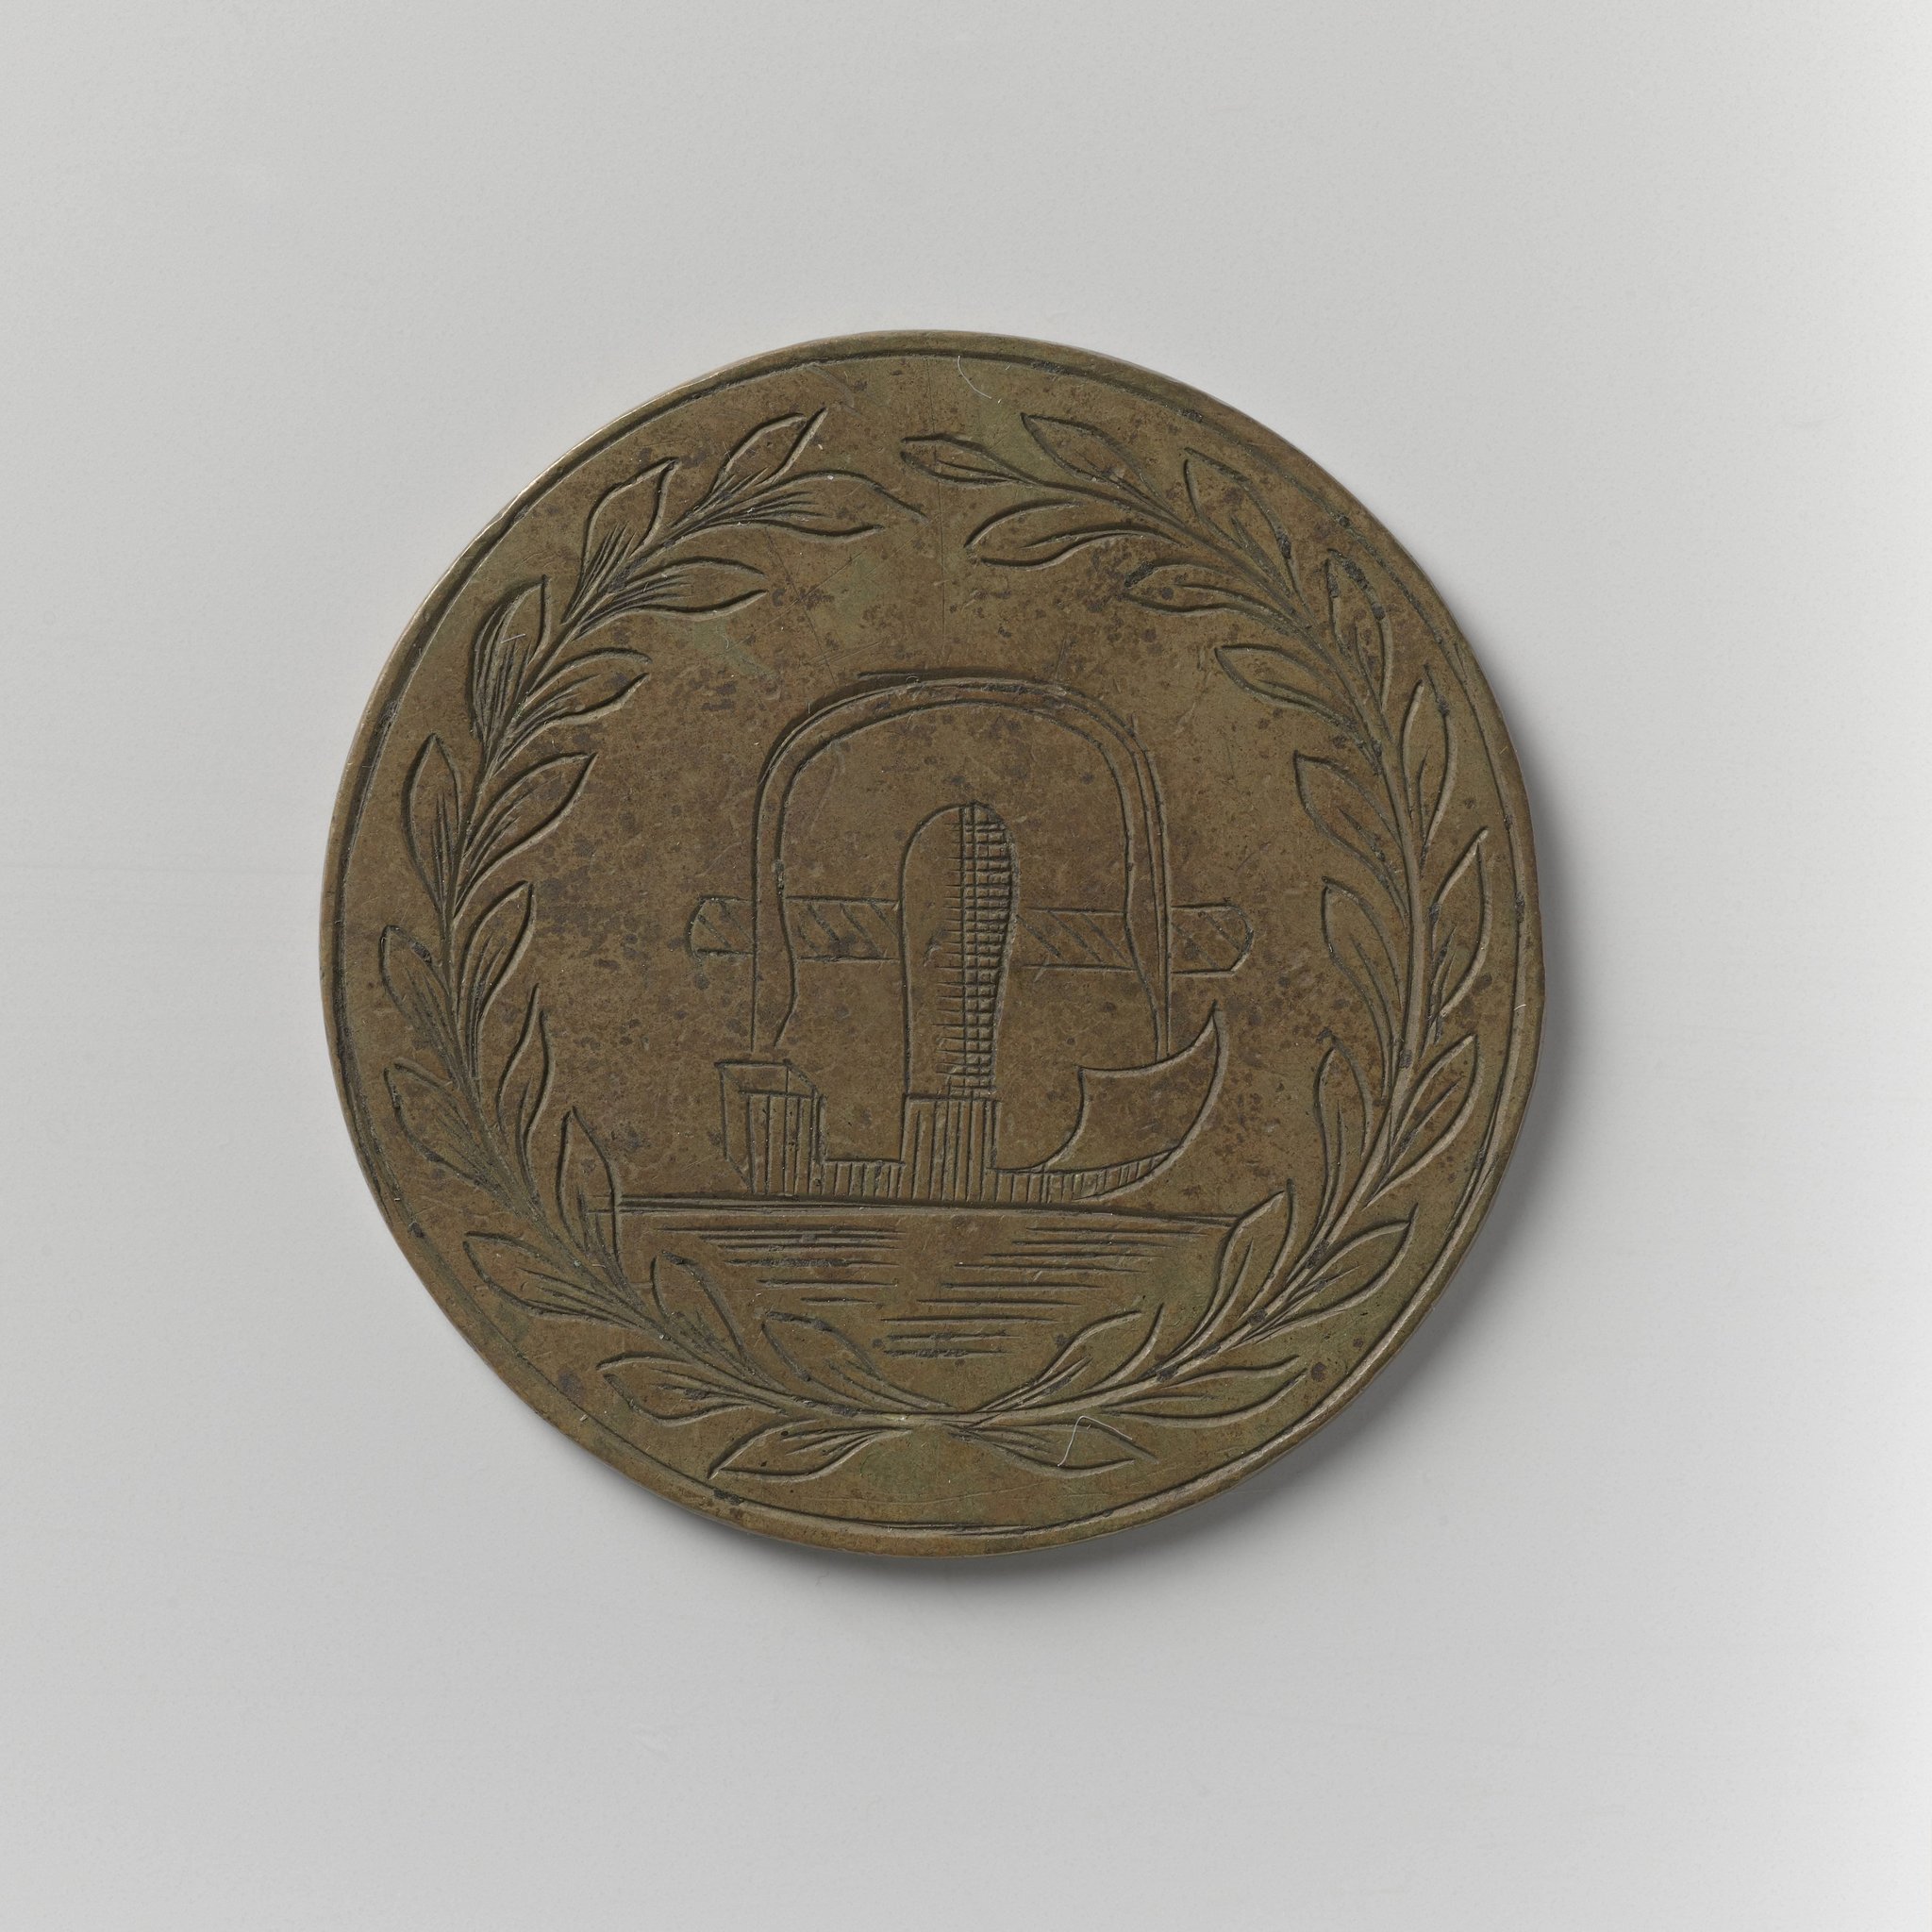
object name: medal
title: Kuipers- en wijnverlatersgilde van Amsterdam, gildepenning van Roelof Bossemaker, meester kuiper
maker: Anonymous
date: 1730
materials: copper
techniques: engraving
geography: amsterdam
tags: amsterdam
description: Koperen penning. Voorzijde: dissel en passer binnen bladerkrans. Keerzijde: opschrift